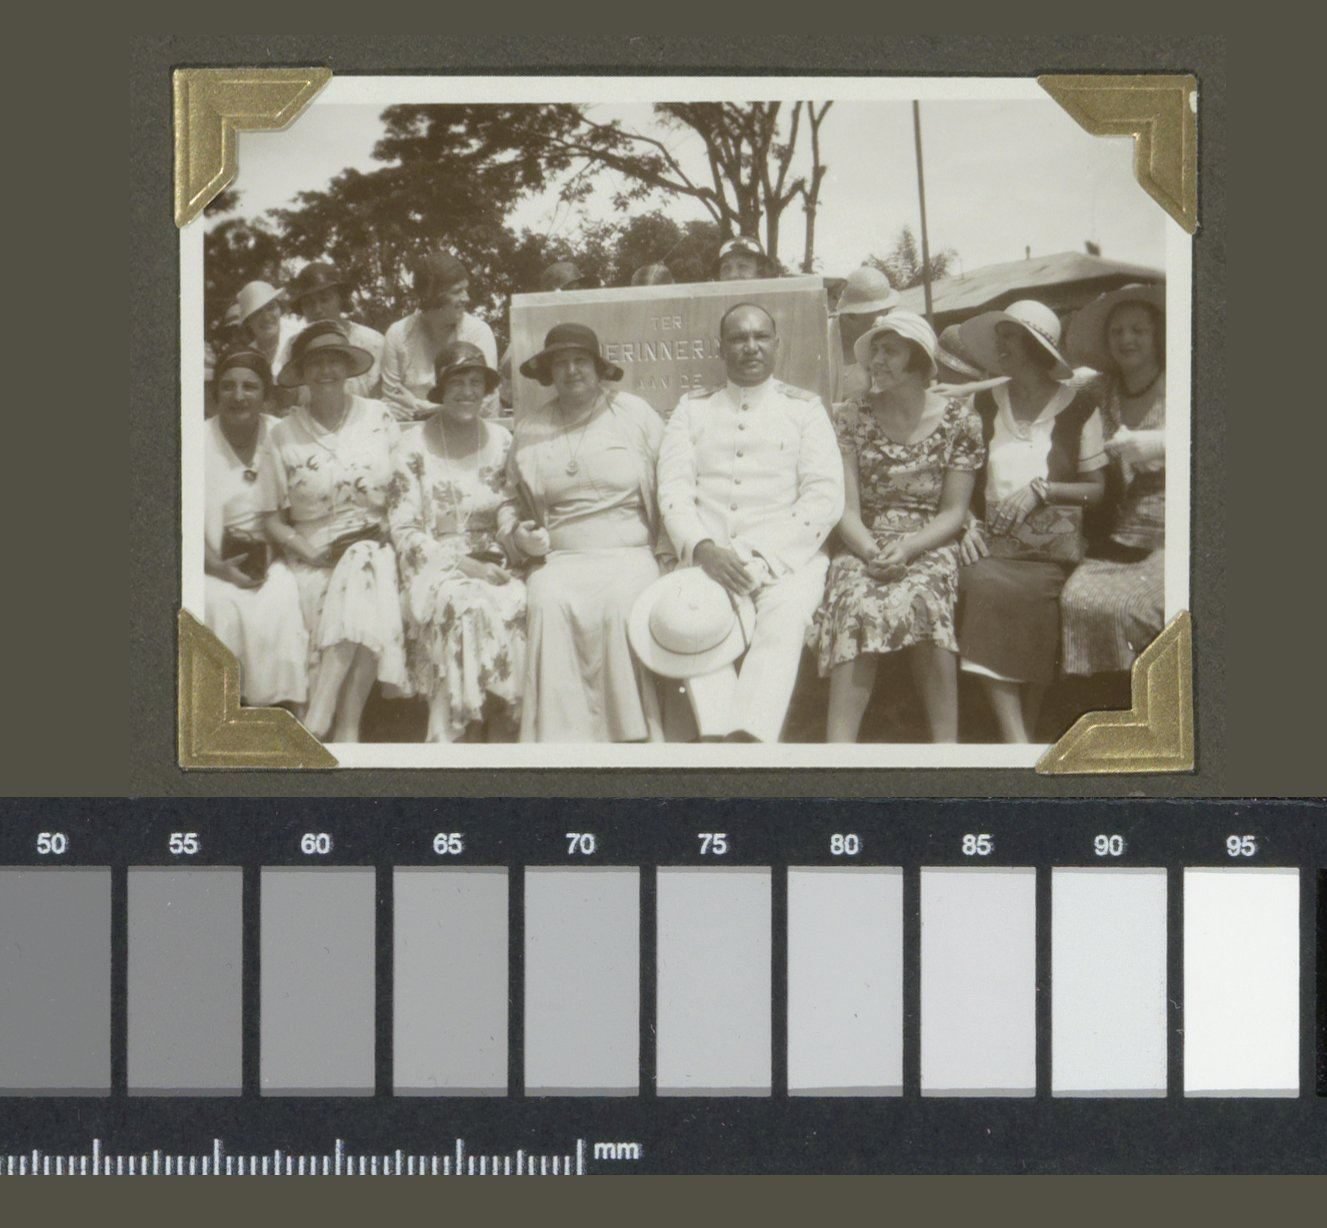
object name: photograph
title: Scheidend resident F.J. Junius met (vermoedelijk) echtgenote en genodigden zittend op de zo juist onthulde 'Junius-bank' in Tandjongkarang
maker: Anonymous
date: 1933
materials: photographic support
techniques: gelatin silver print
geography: lampung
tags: resident, f.j. junius, lampong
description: De 'Junius-bank' werd in Tandjongkarang op 21 mei 1933 onthuld ter herinnering aan de bestuursperiode (1930-1933) van resident F.J. Junius.